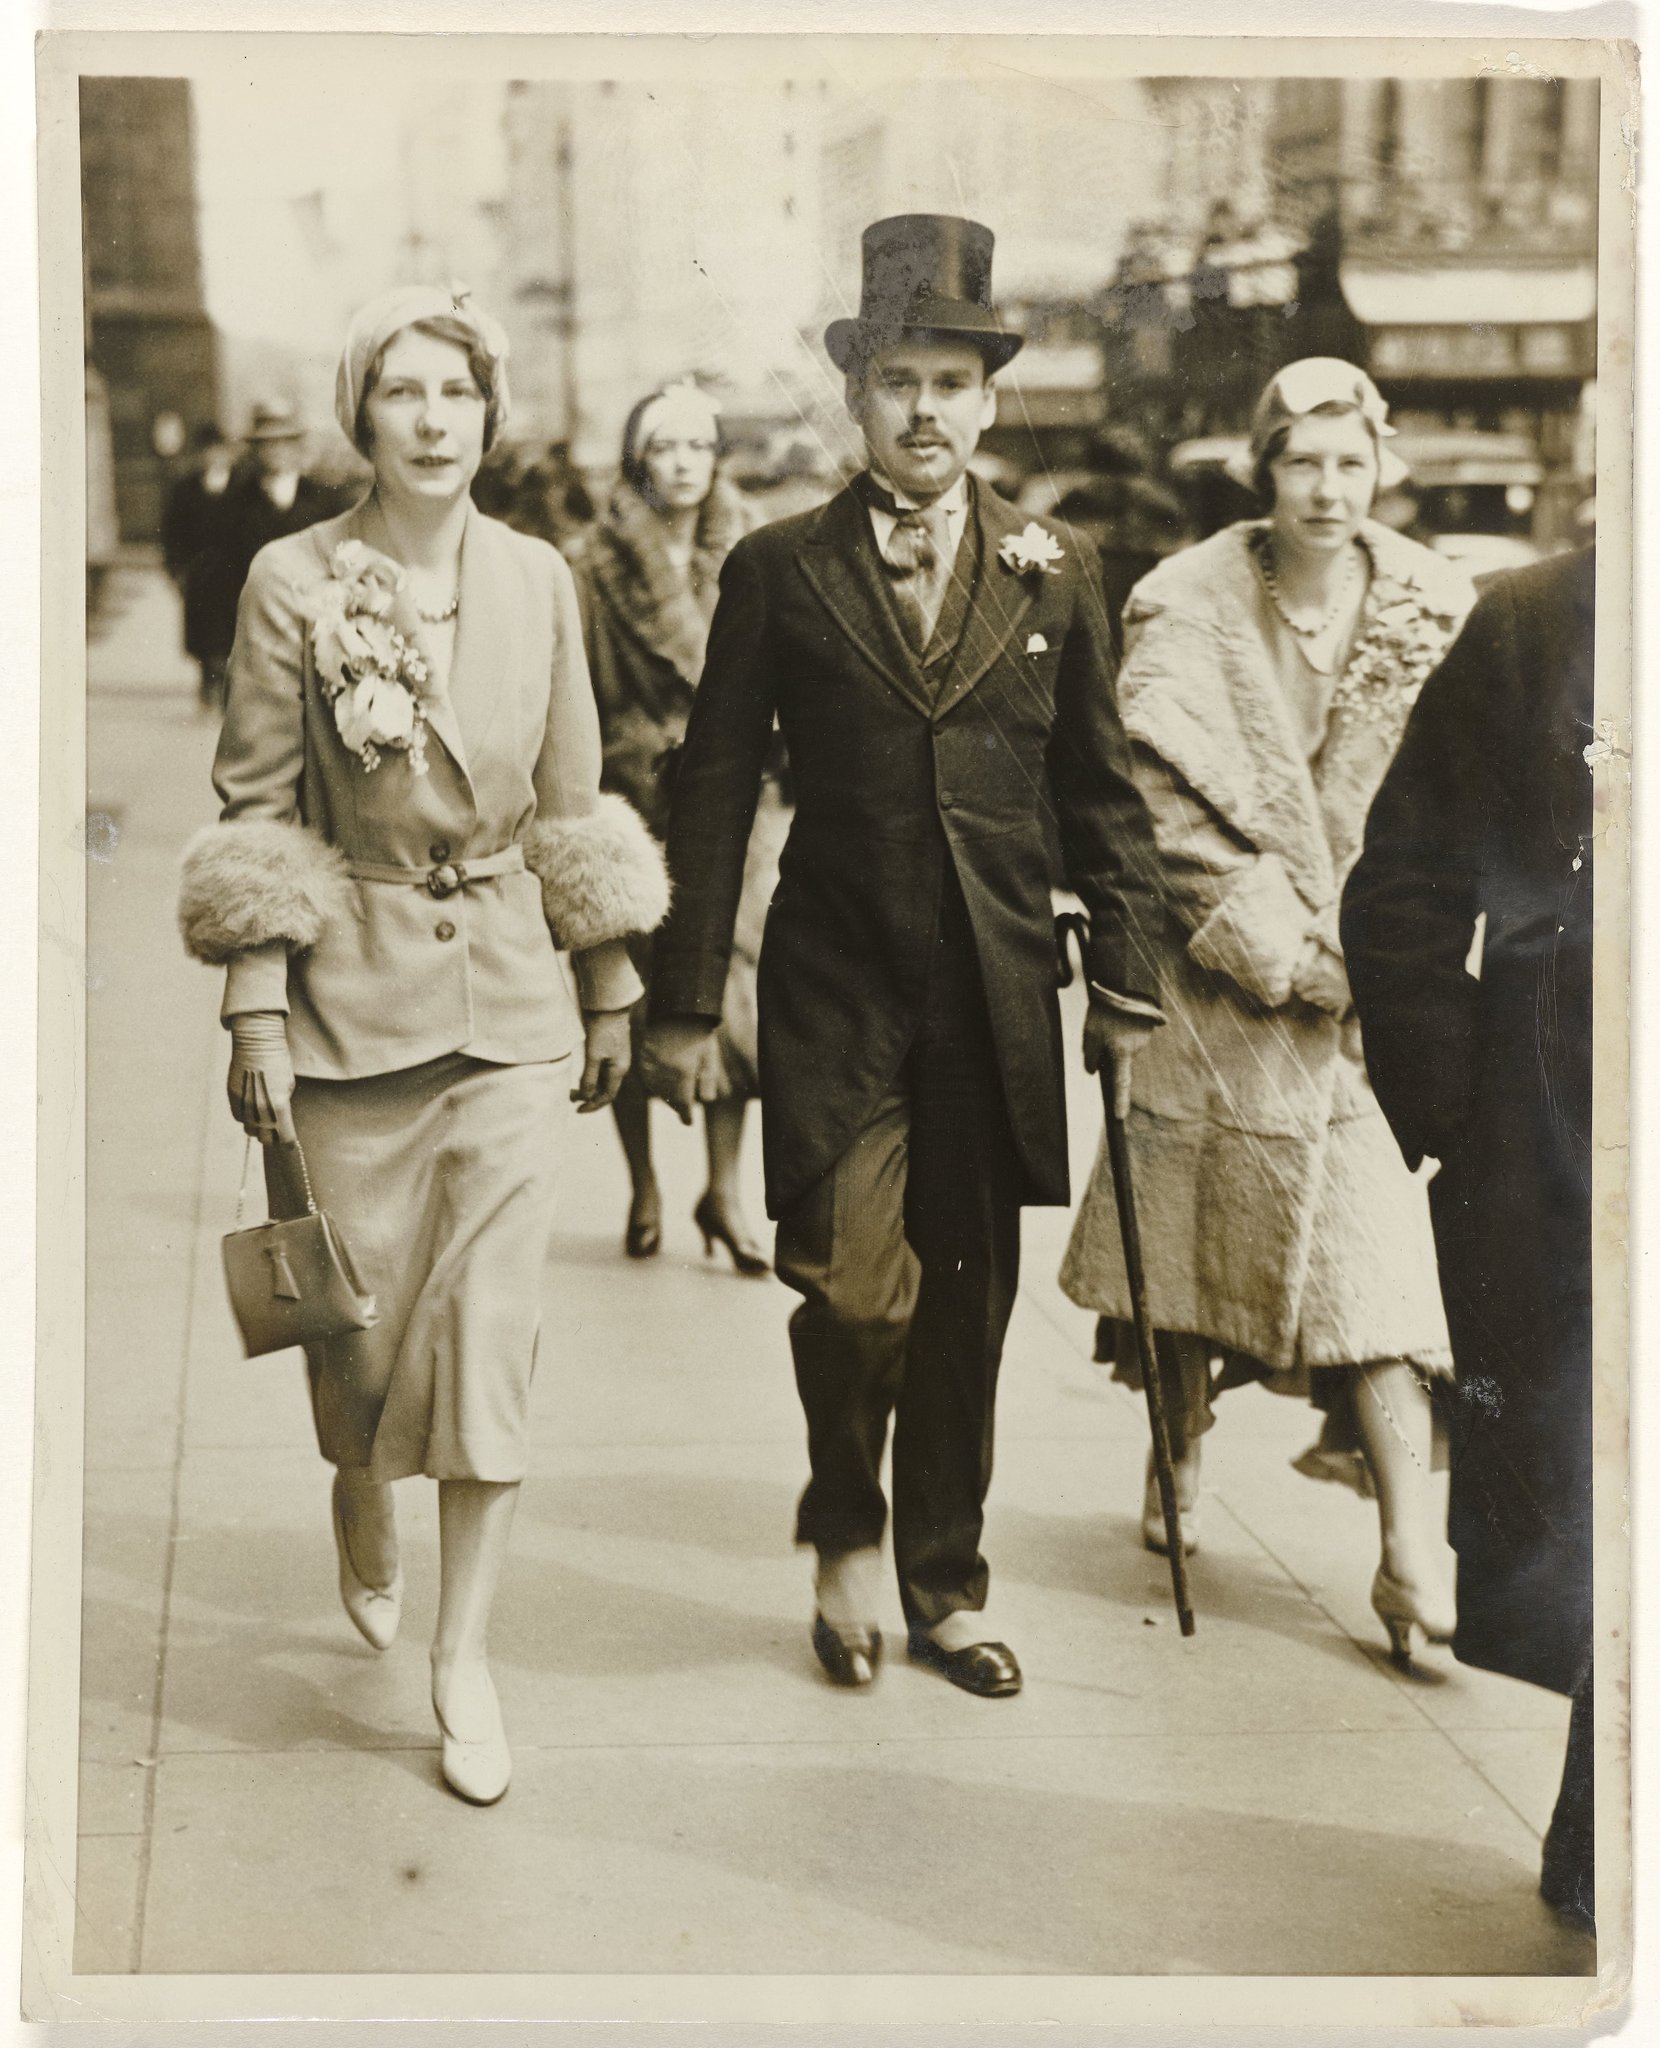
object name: photograph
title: Modieus geklede vrouw op straat, New York City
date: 1930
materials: paper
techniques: gelatin silver print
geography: new york city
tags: dandy, beau, fashionable woman, 'belle', street (+ city(-scape) with figures, staffage), new york (city)